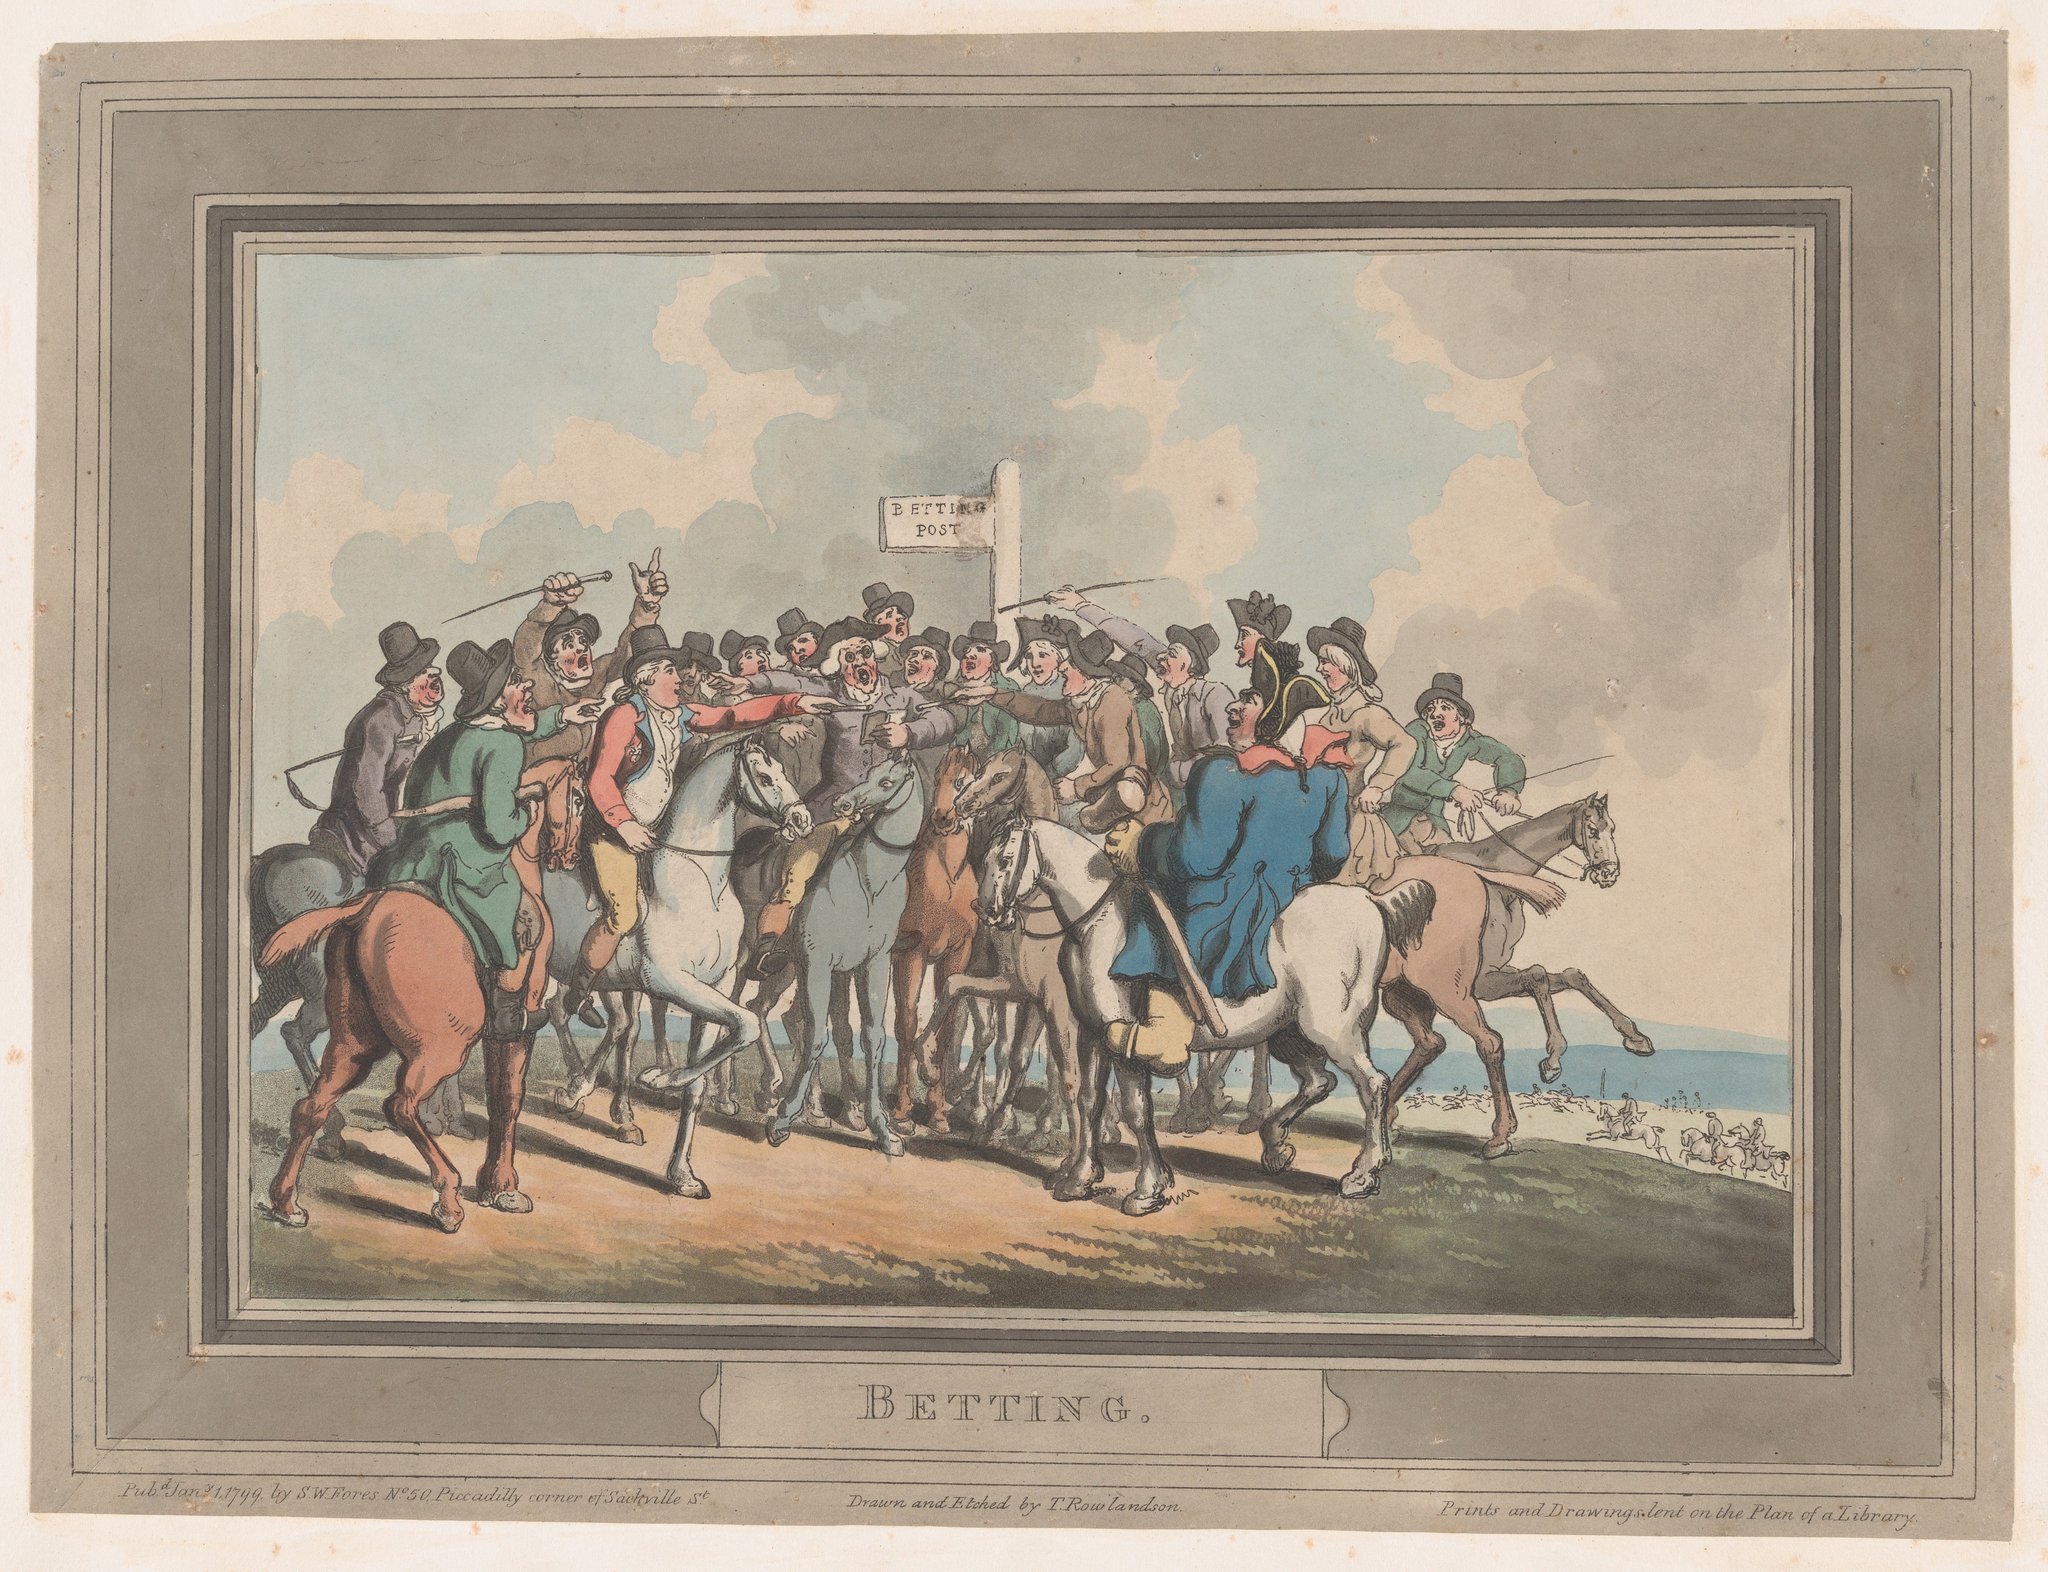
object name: print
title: Betting [The Betting Post]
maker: thomas rowlandson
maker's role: artist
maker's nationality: british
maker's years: 1757-1827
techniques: aquatint, etching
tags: men,gambling,horses